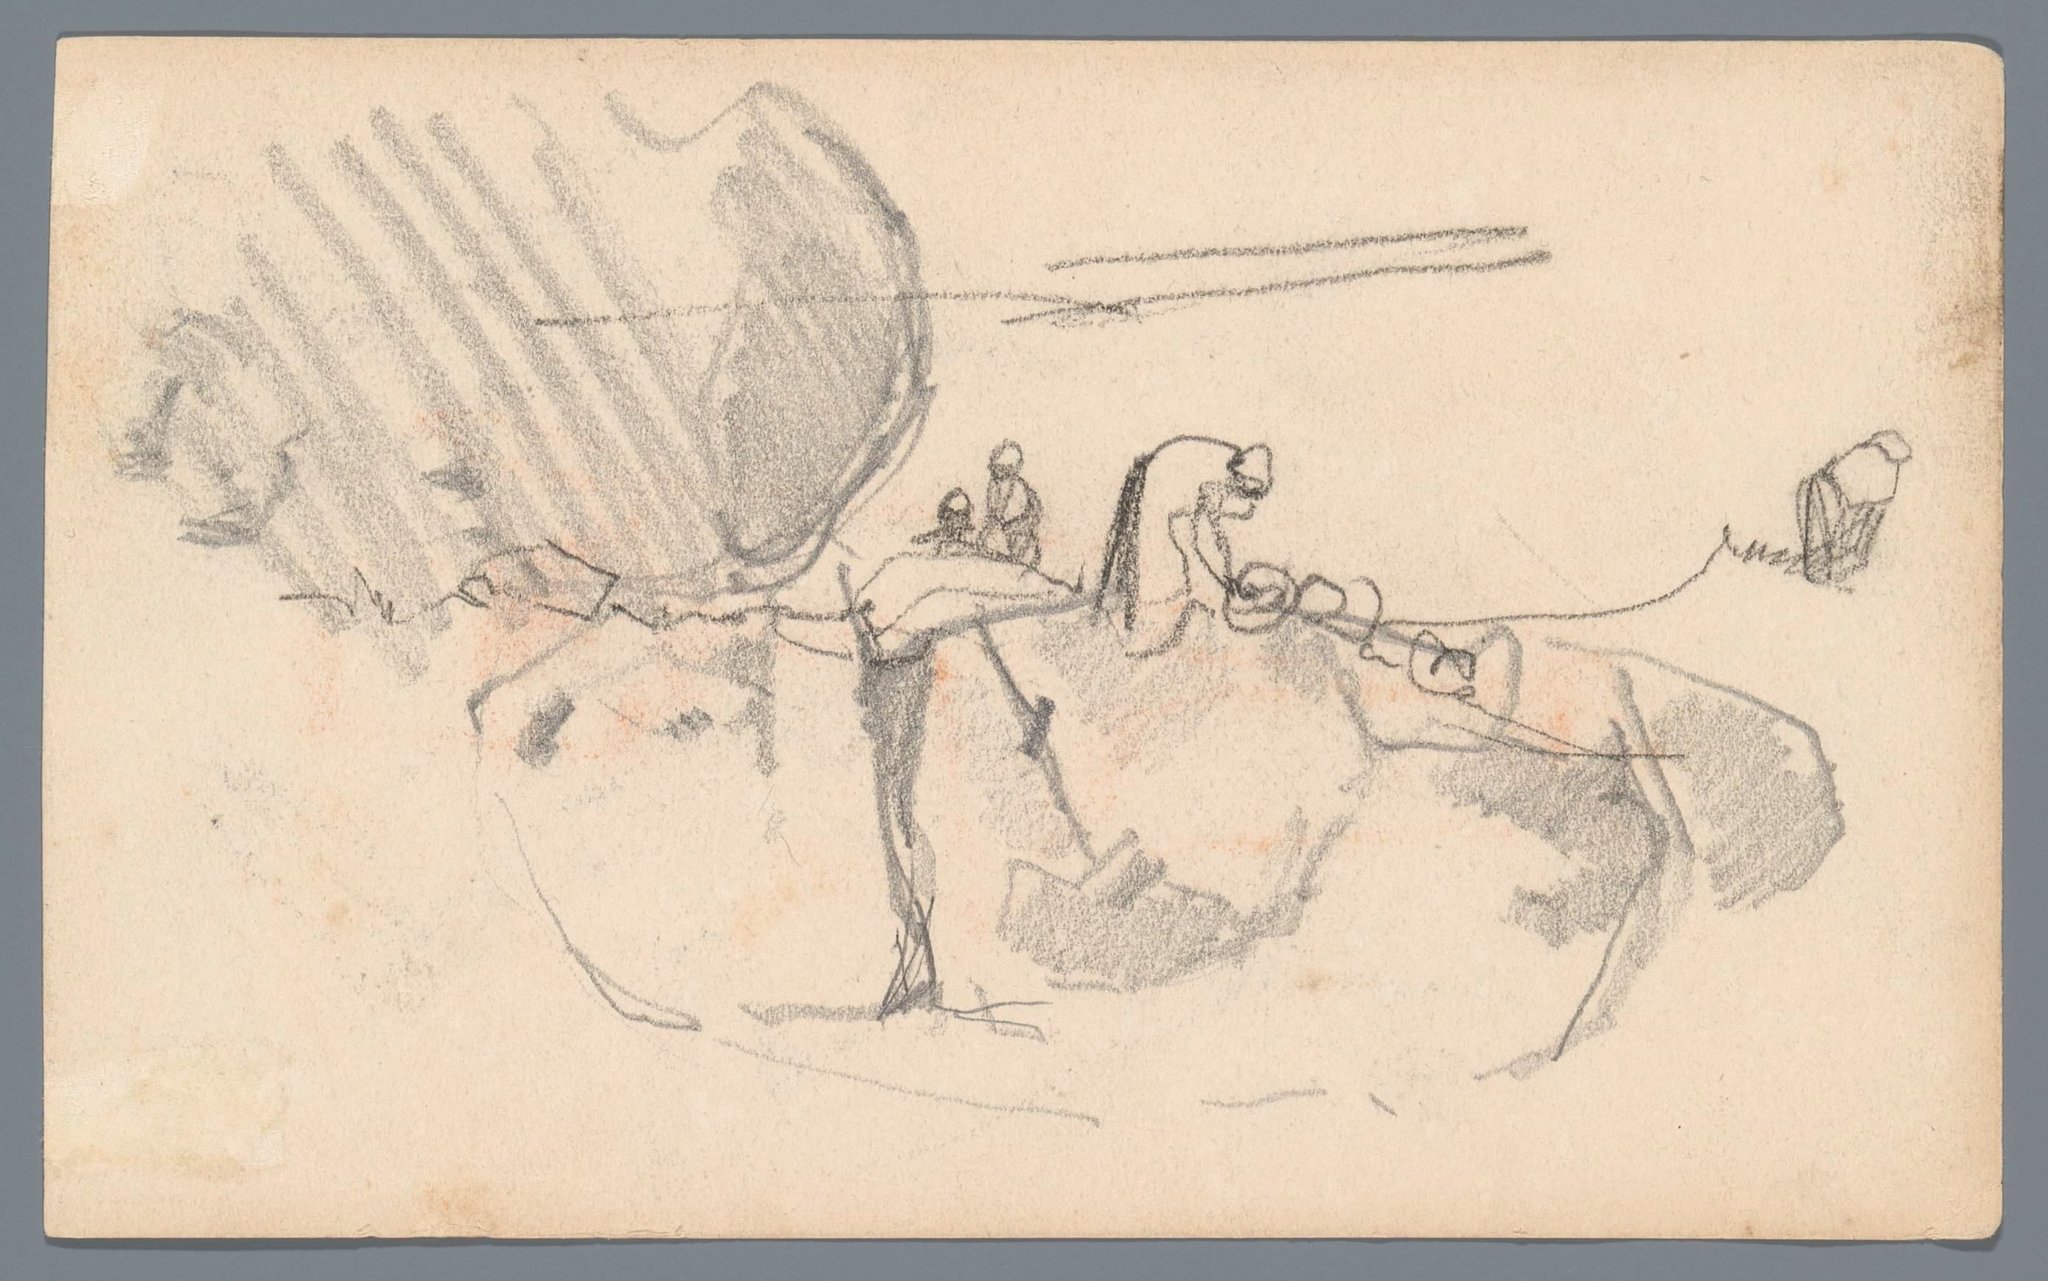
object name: drawing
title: Figuurstudies, mogelijk vrouwen die aan het werk zijn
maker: george hendrik breitner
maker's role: draughtsman, painter, print maker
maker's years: 1857-1923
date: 1880-1882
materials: chalk, paper, pencil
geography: rotterdam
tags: adult woman